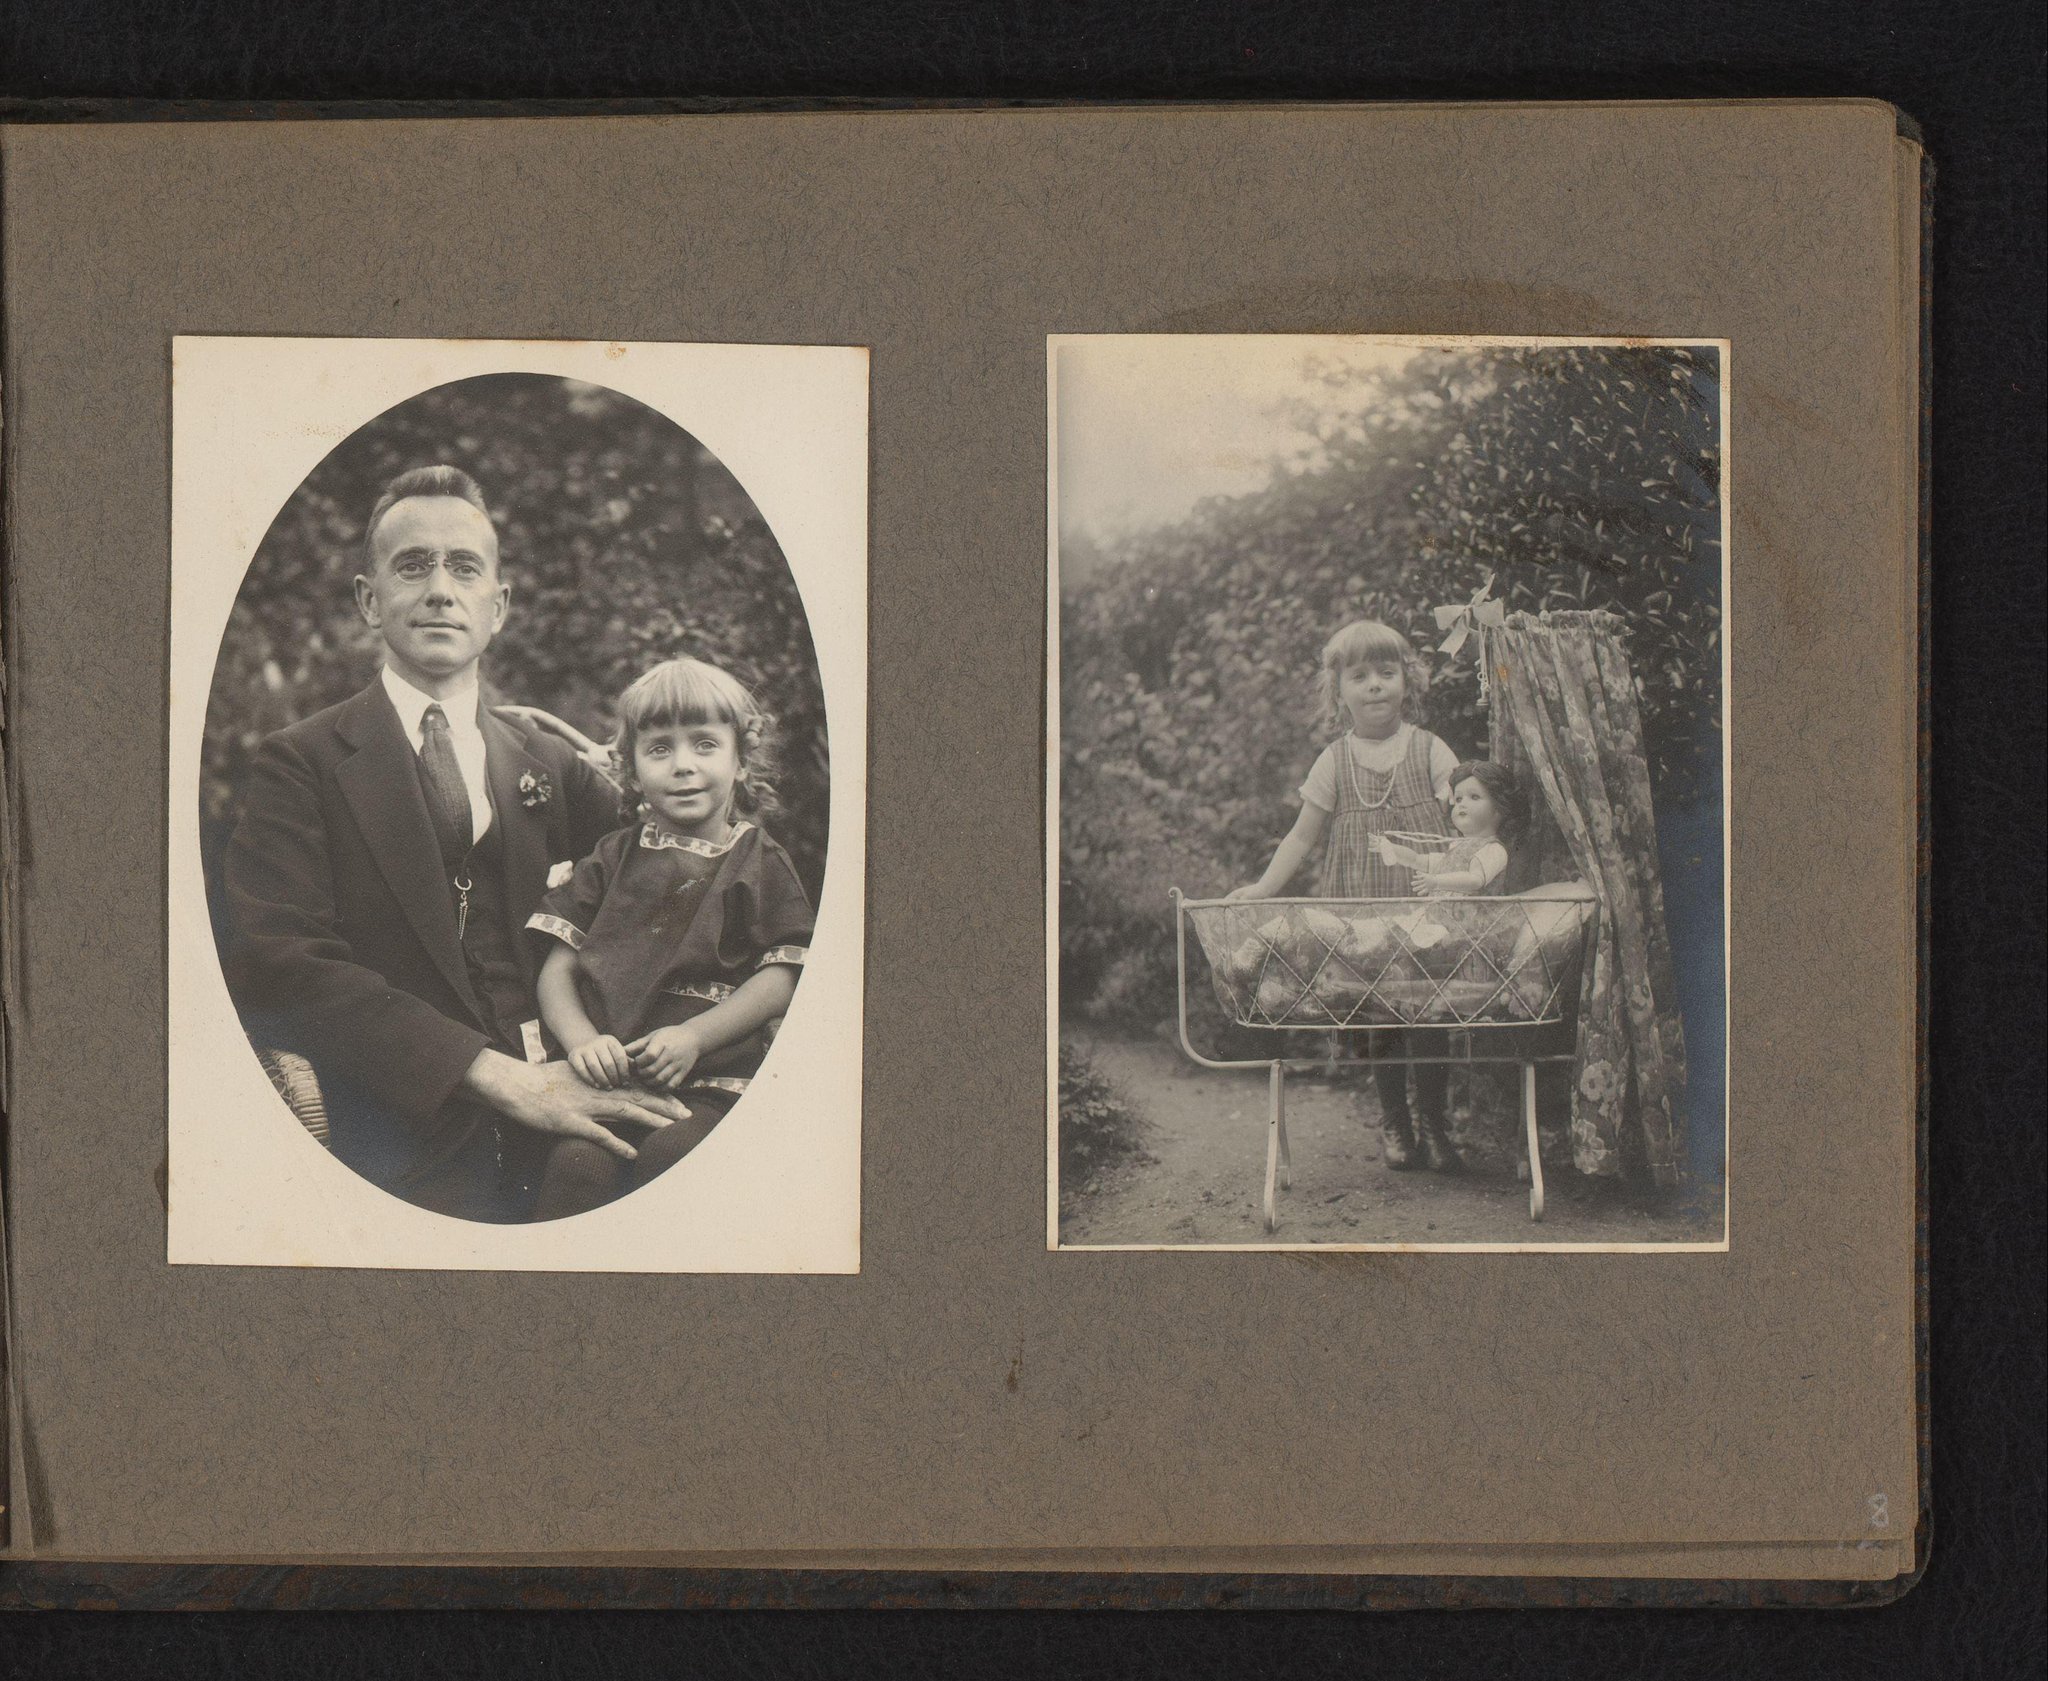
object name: album leaf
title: Vader en dochter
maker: Anonymous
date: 1900-1912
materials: cardboard, photographic support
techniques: gelatin silver print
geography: netherlands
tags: parents with their children, girl (child between toddler and youth), (playing with) dolls, netherlands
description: Albumblad met twee foto's van de vader met zijn dochter op schoot en van het meisje met een poppenwagen in de tuin. Onderdeel van een familiealbum uit de periode 1900-1912.